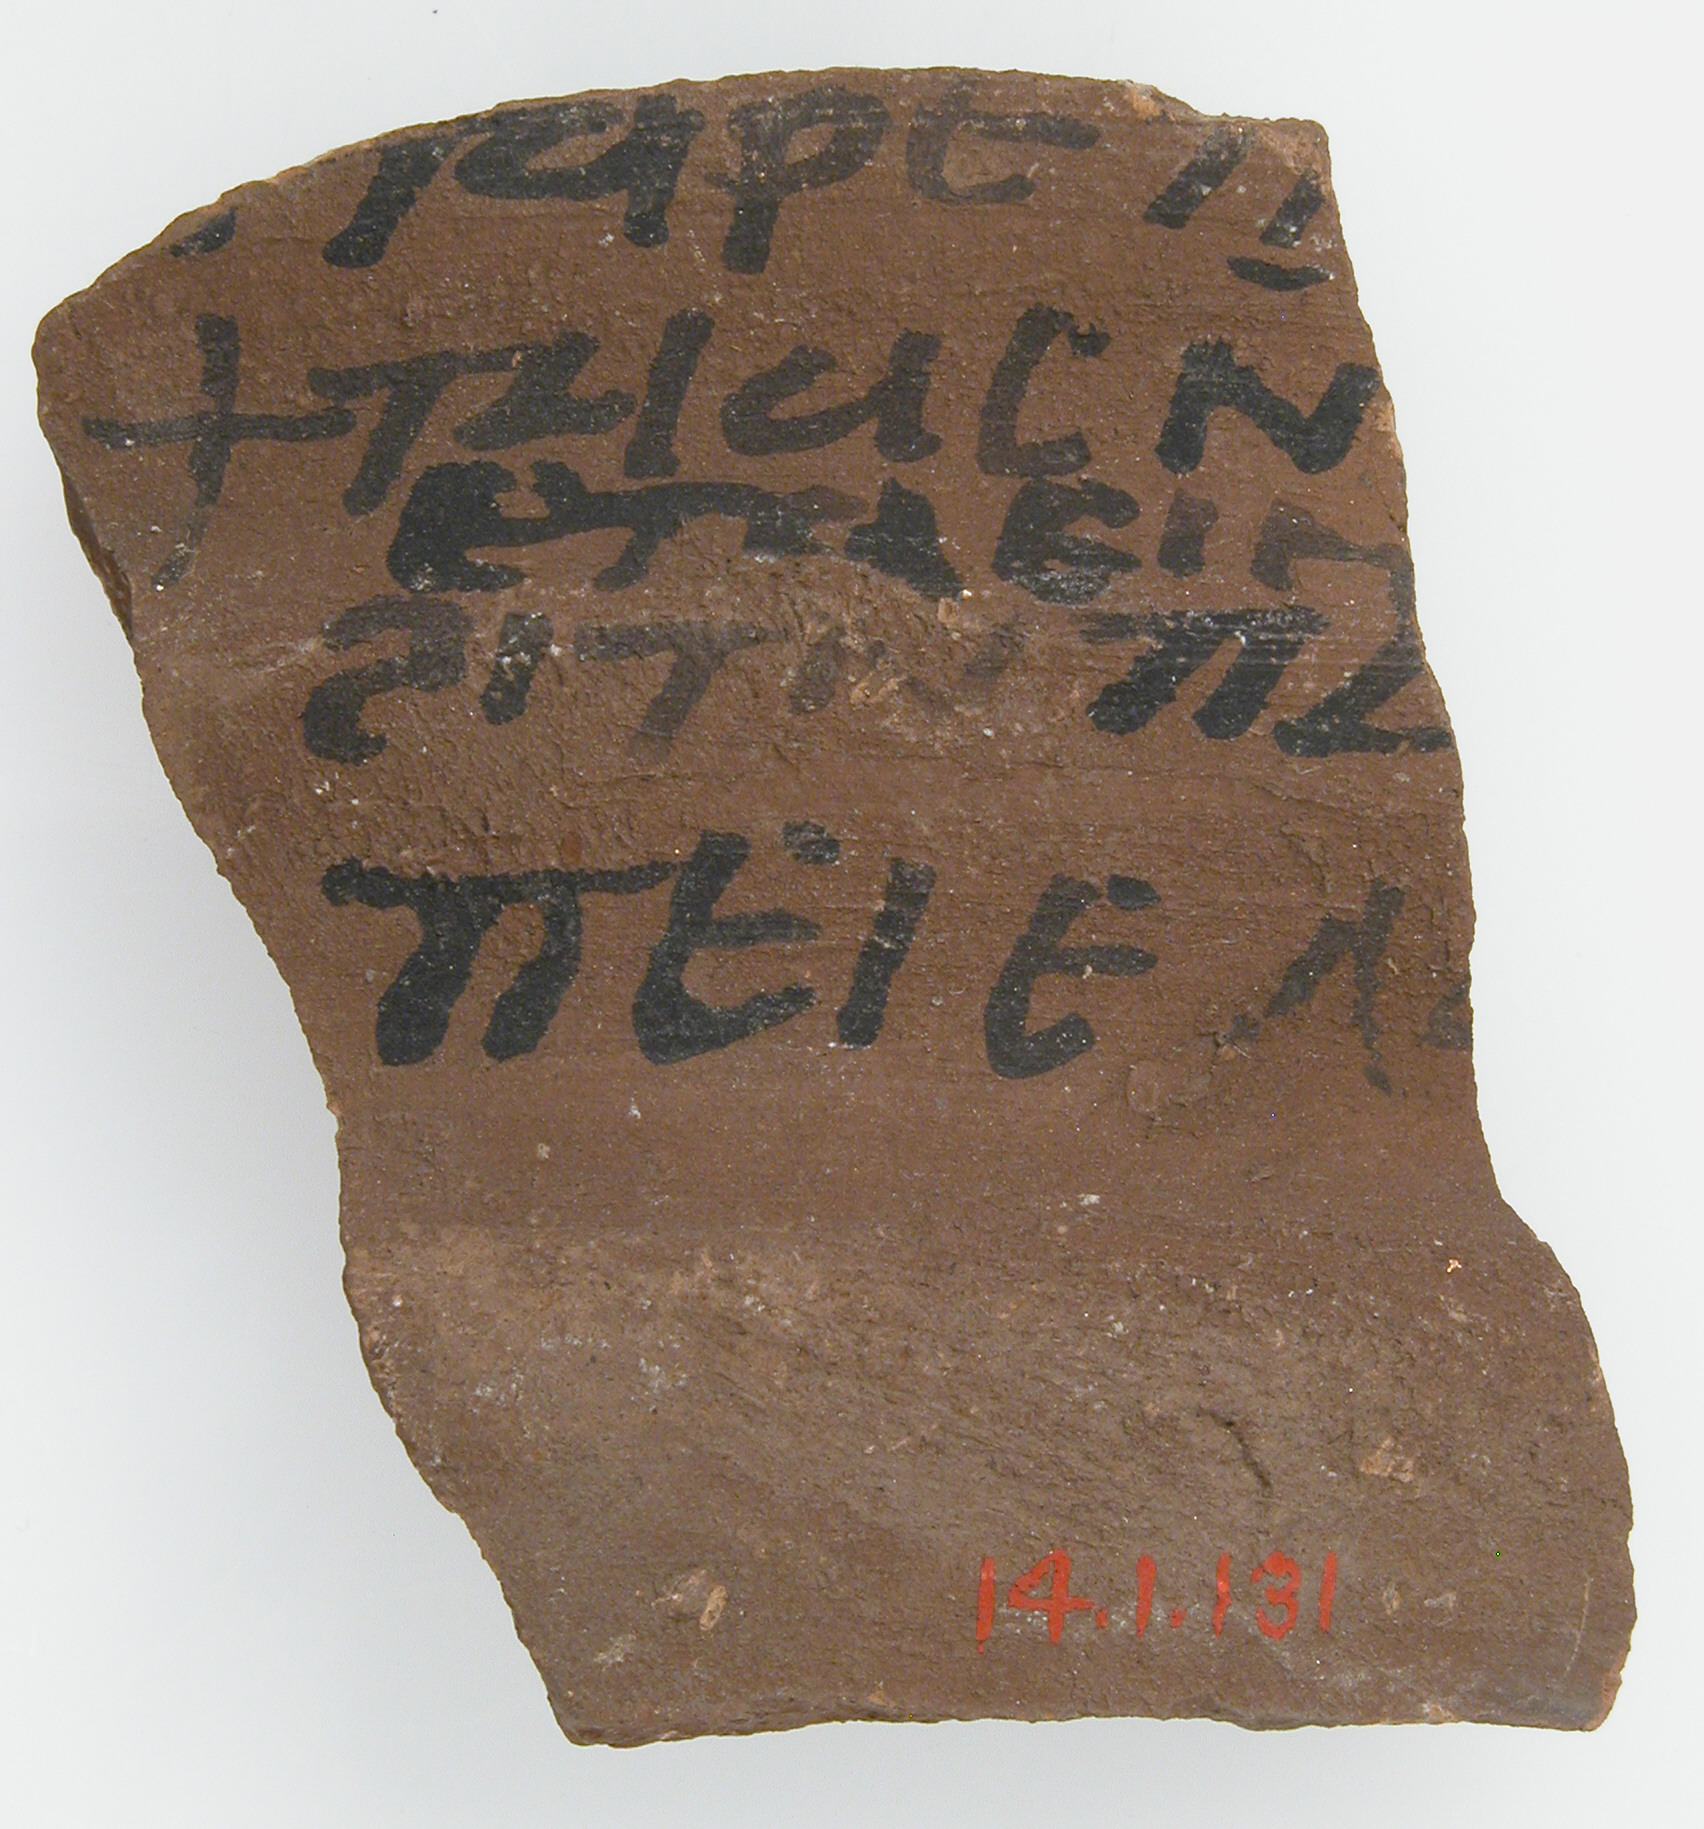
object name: ostrakon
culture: coptic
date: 600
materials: ink, pottery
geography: egypt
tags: coptic,documents